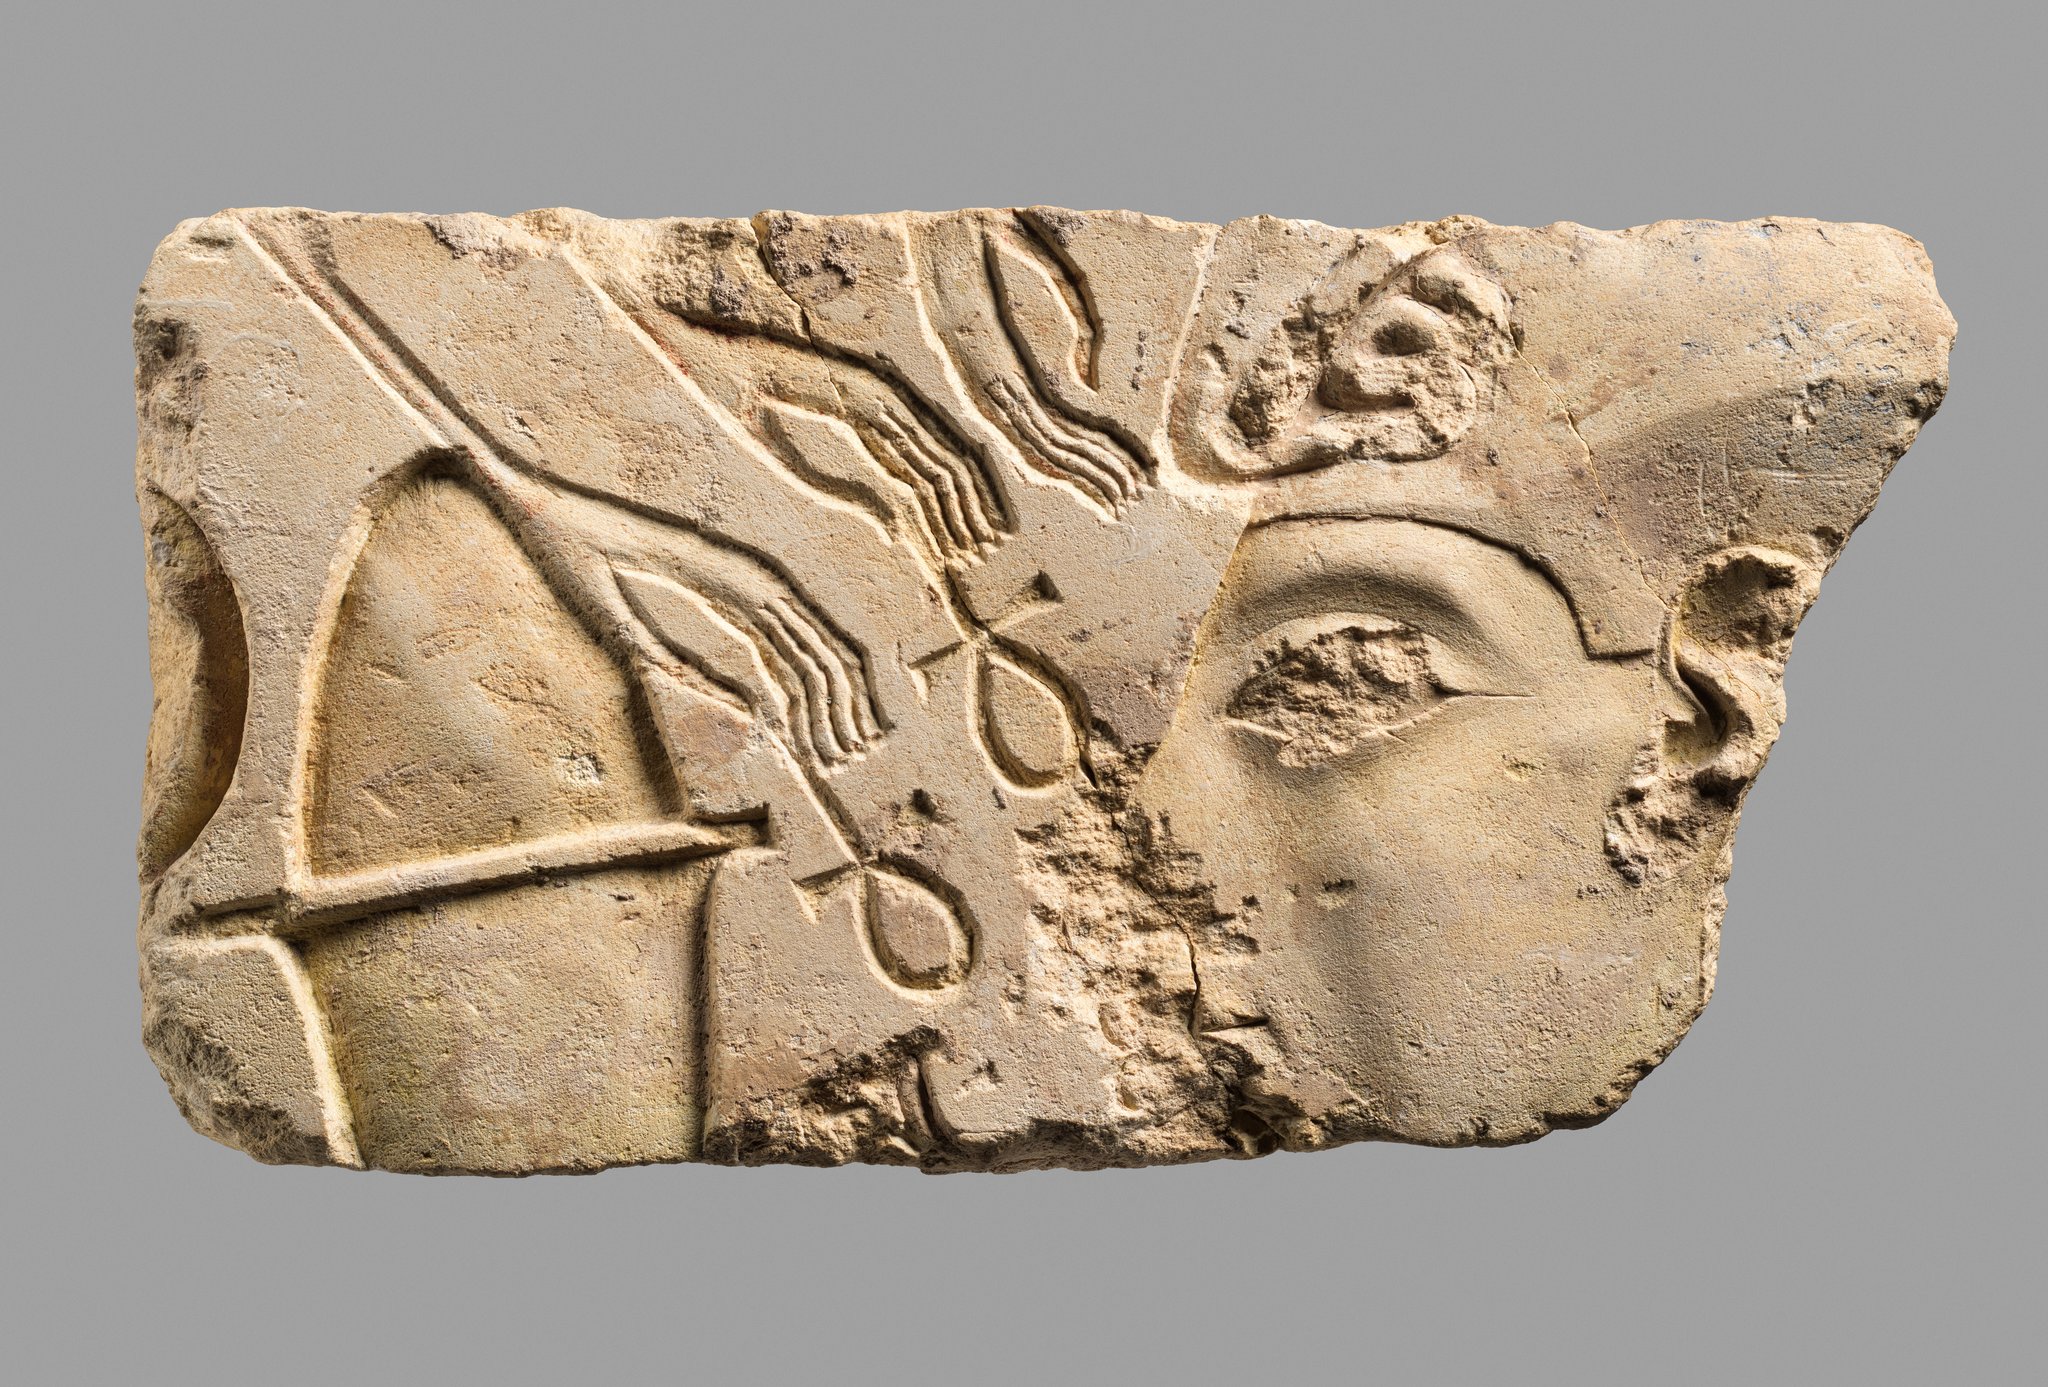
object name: talatat, queen's face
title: Relief showing the Aten interacting with the queen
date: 1352-1336 BCE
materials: limestone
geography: egypt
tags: women